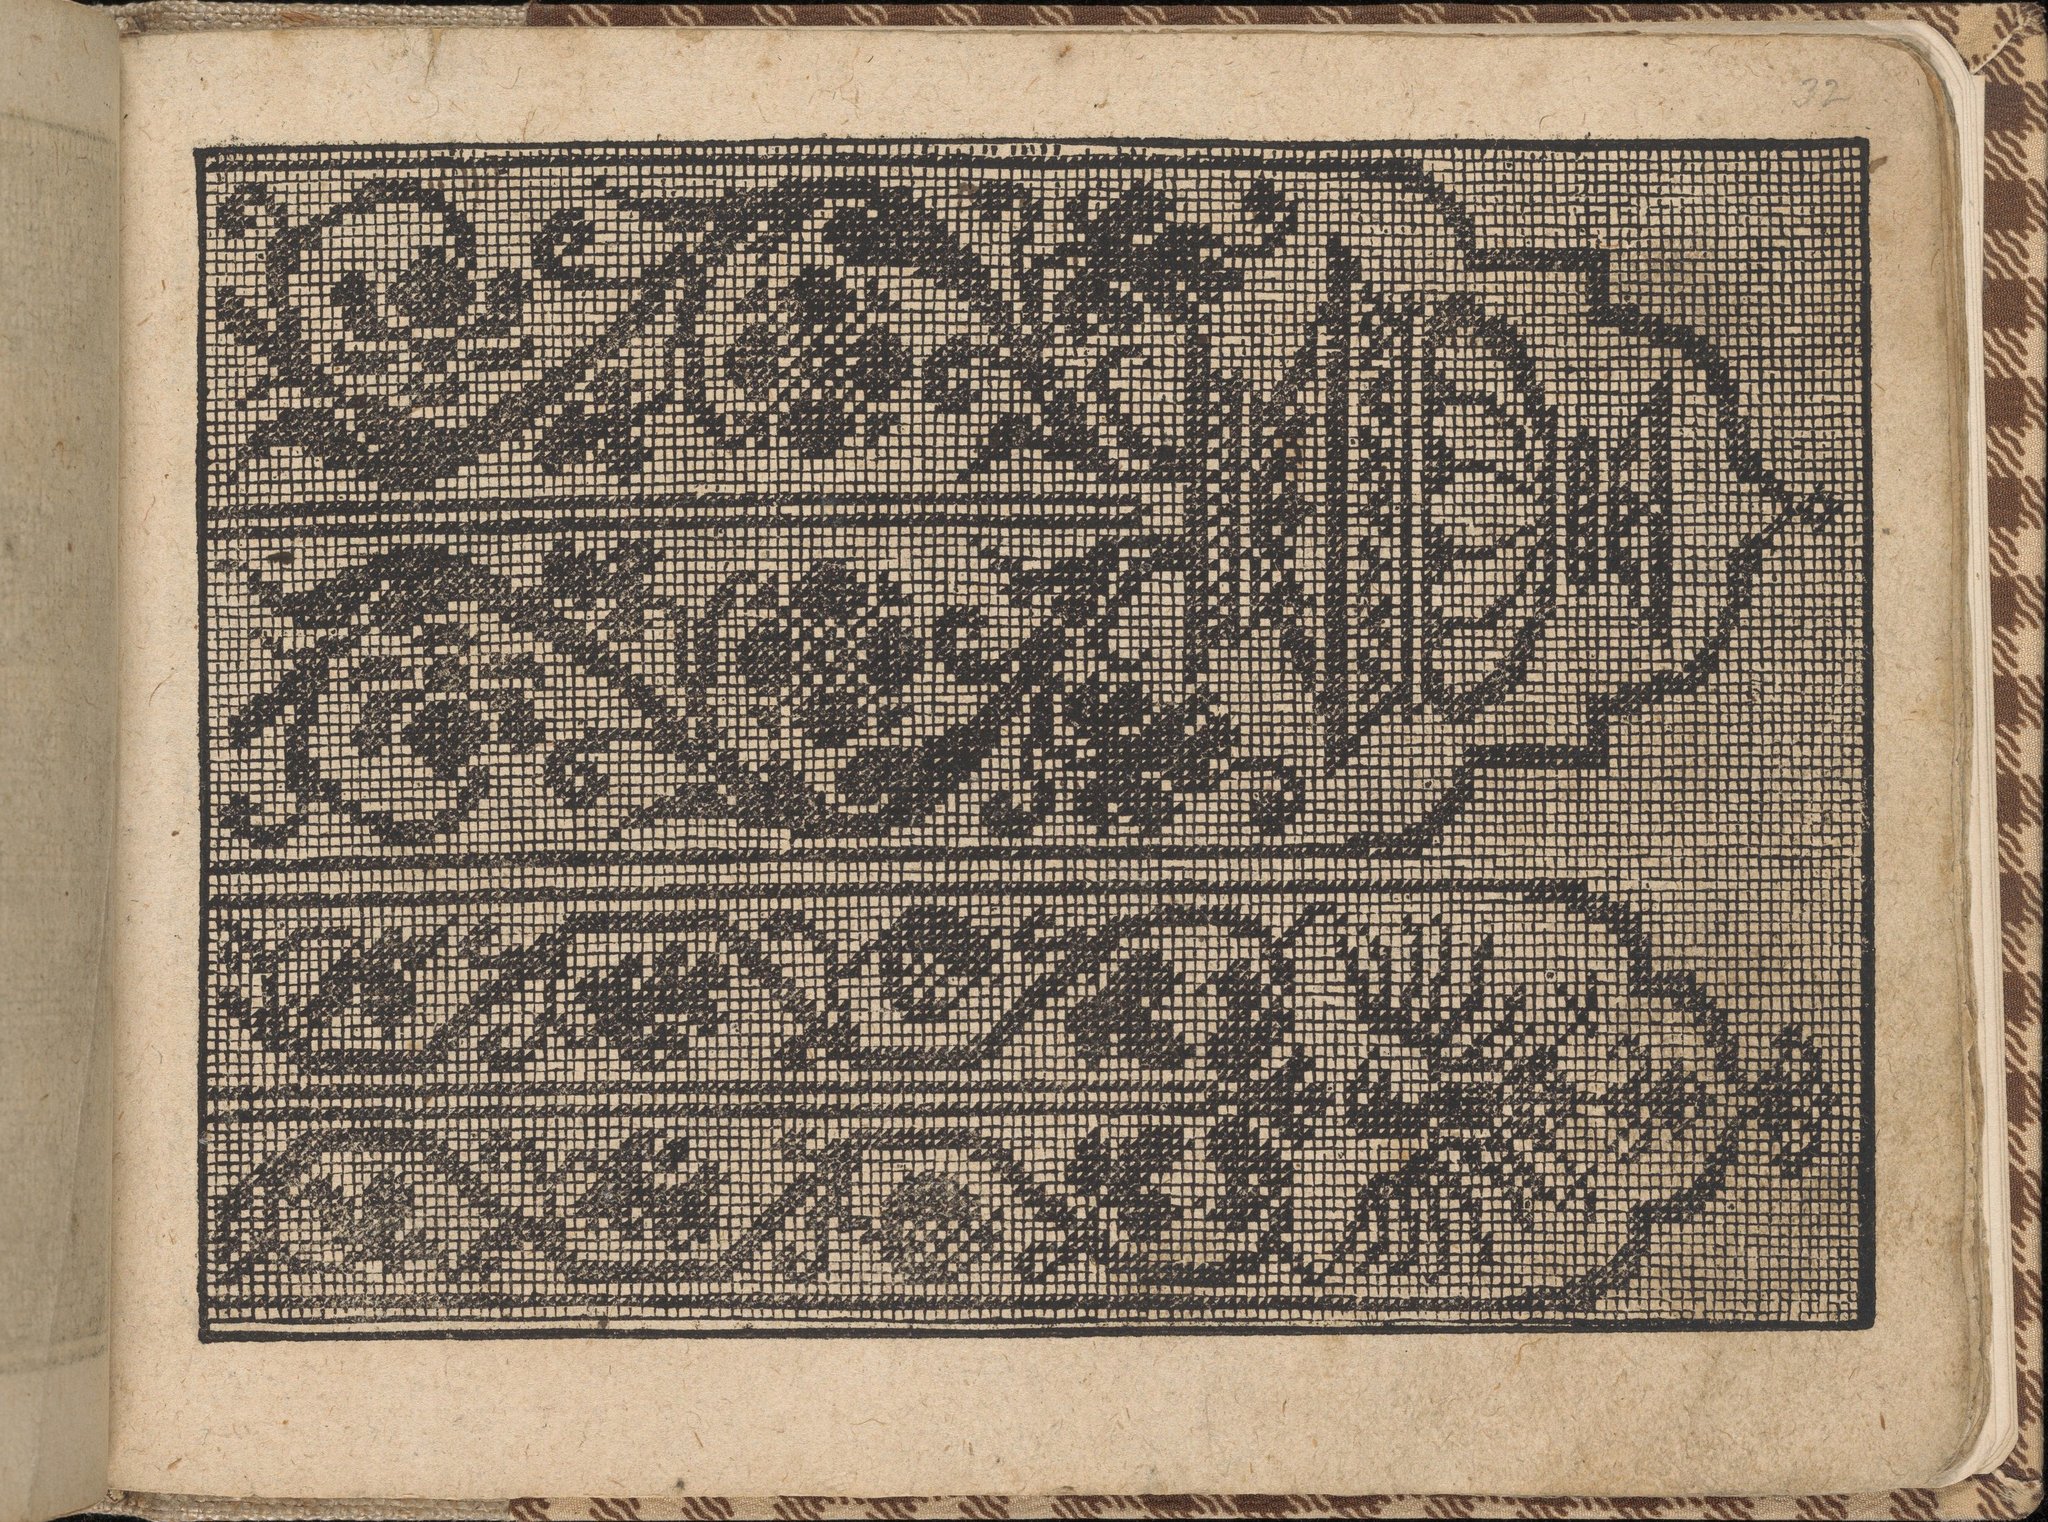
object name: book print ornament architecture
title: New Künstlichs Modelbuch (Page 32 recto)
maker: bernhard jobin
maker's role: publisher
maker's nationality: swiss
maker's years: 1535-1597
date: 1600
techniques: woodcut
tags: birds,flowers